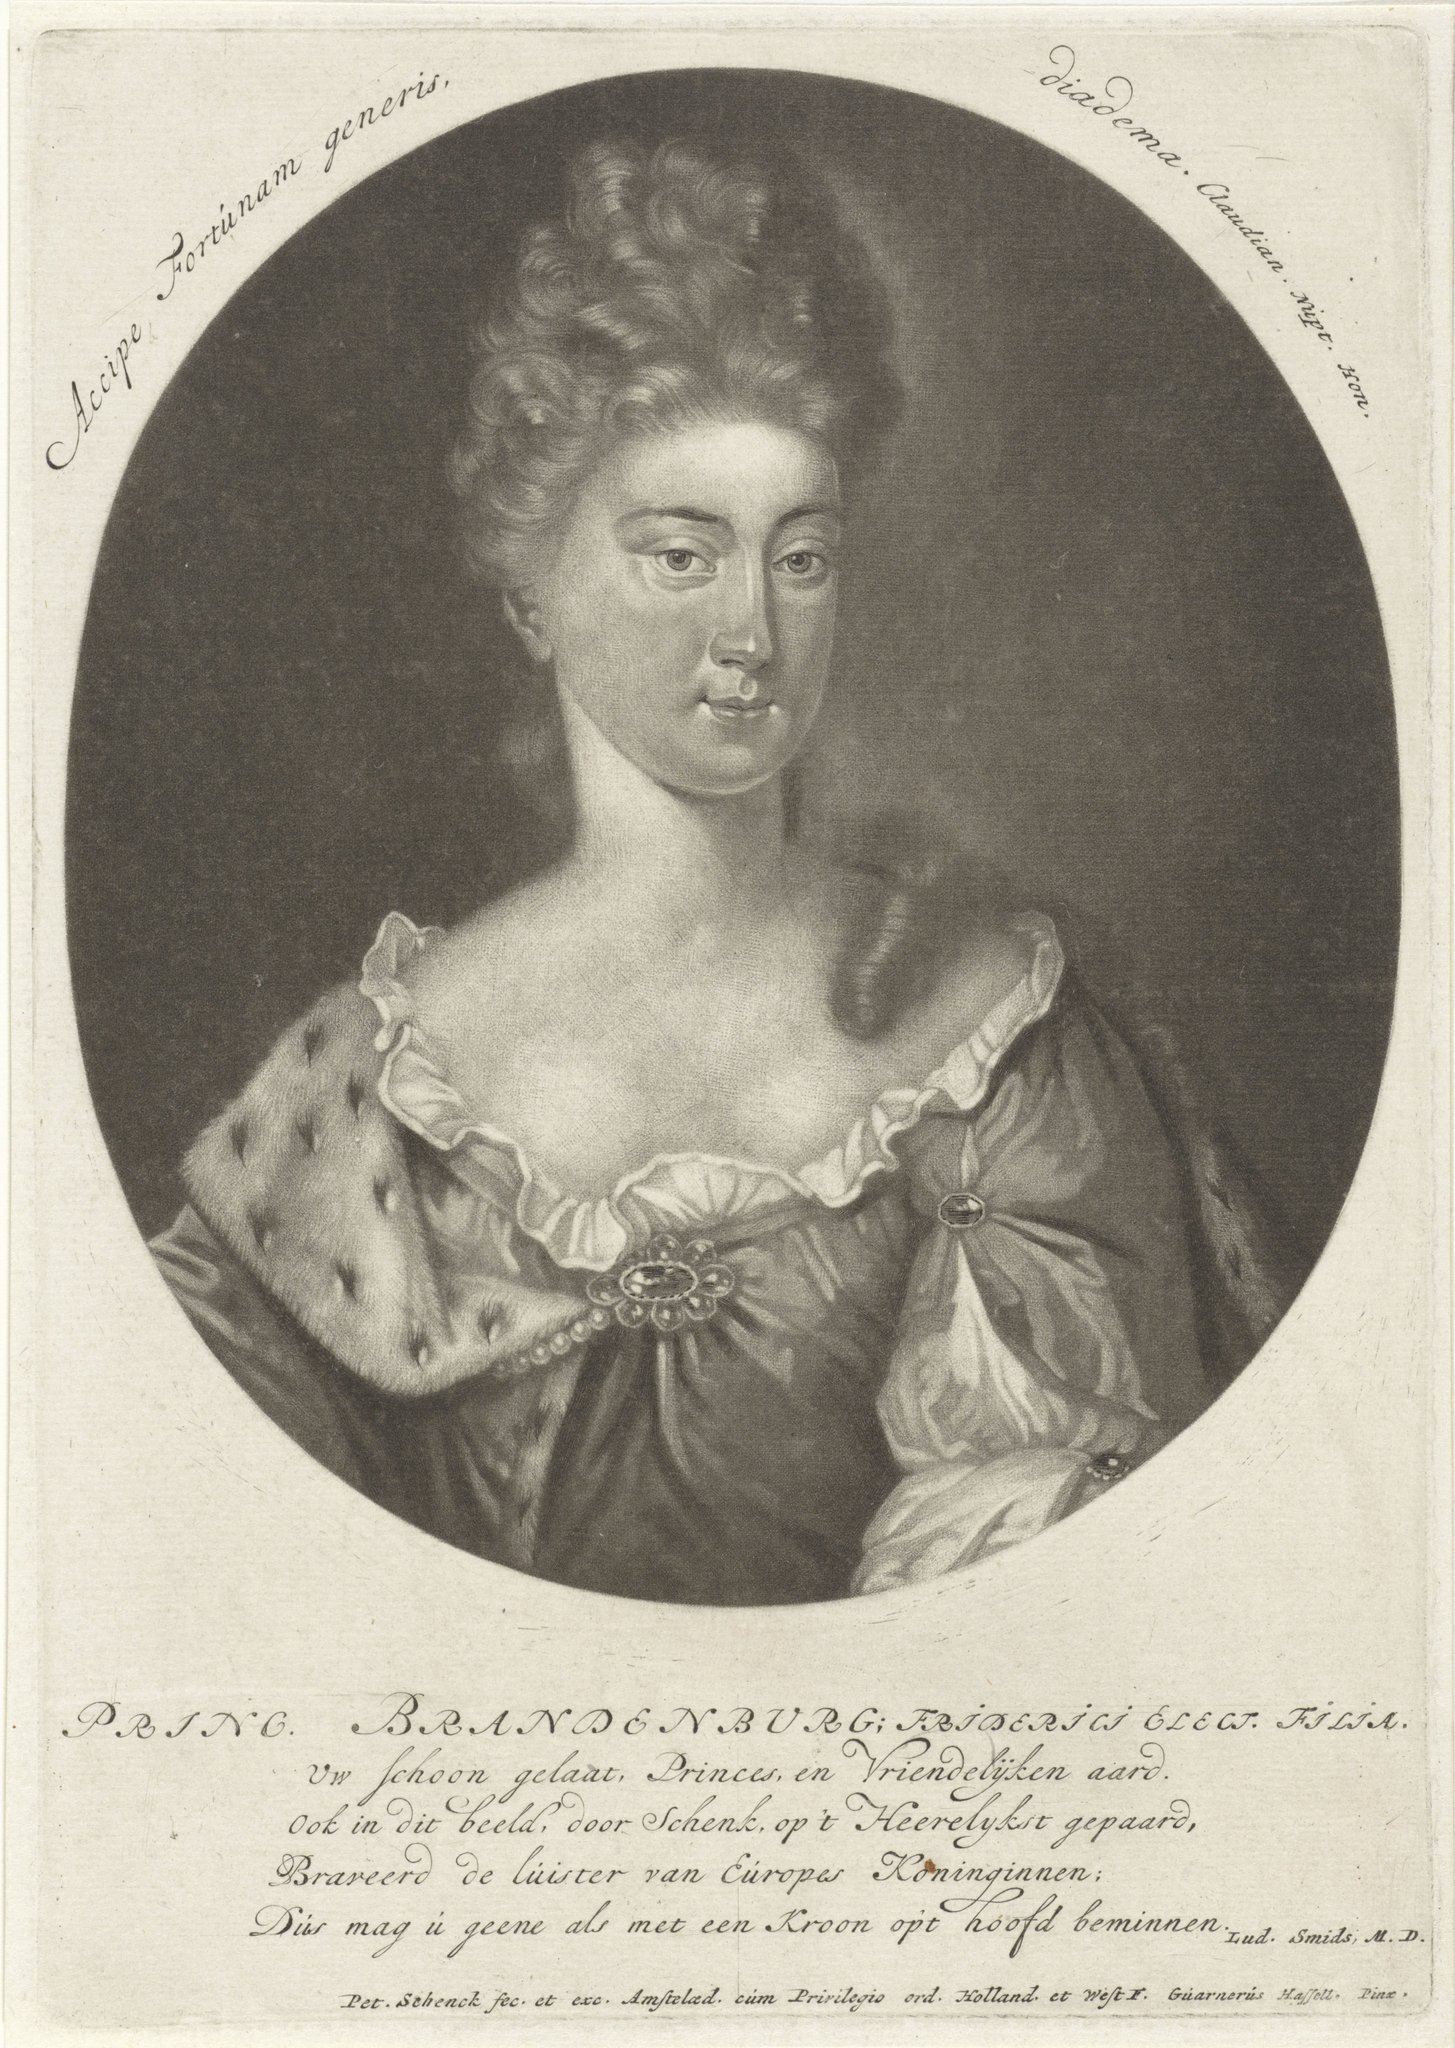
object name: print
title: Portret van Sophia Charlotte, koningin van Pruisen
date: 1698-1713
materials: paper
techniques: engraving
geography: amsterdam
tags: iburg, koningin, sophia charlotte (koningin van pruisen)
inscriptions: collector's mark: Lugt 2028, collector's mark: Lugt 2228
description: Sophia Charlotte van Hannover, koningin van Pruisen. In de marge een gedicht, haar naam en titels.